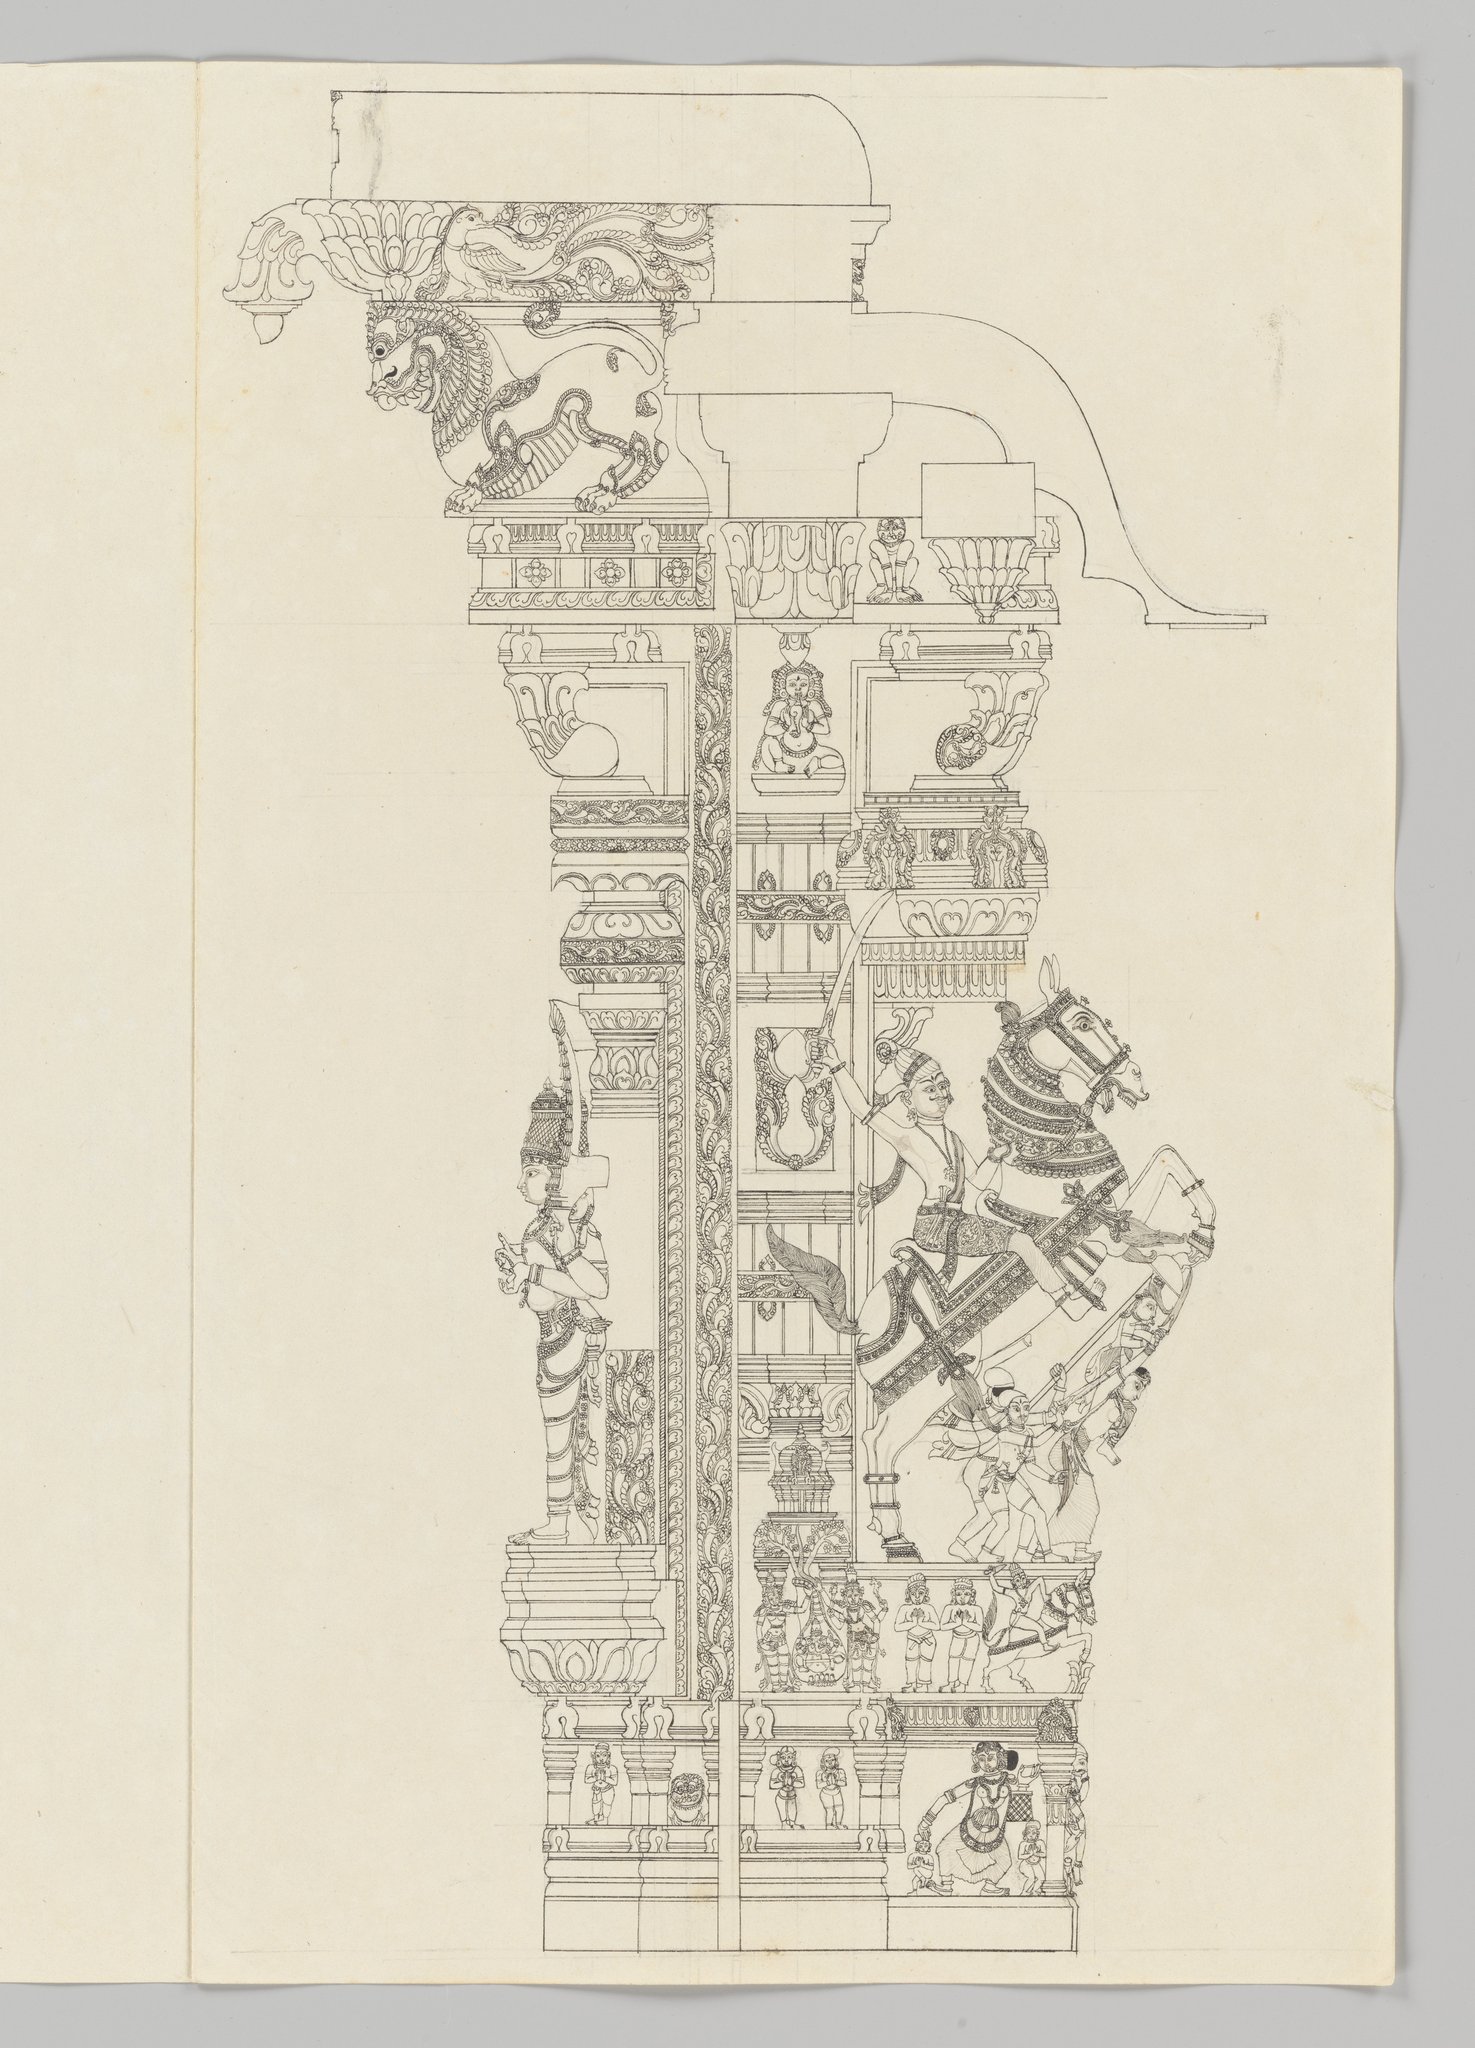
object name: drawing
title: Subramanya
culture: indian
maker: unidentified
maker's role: artist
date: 1800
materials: ink, paper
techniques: wash